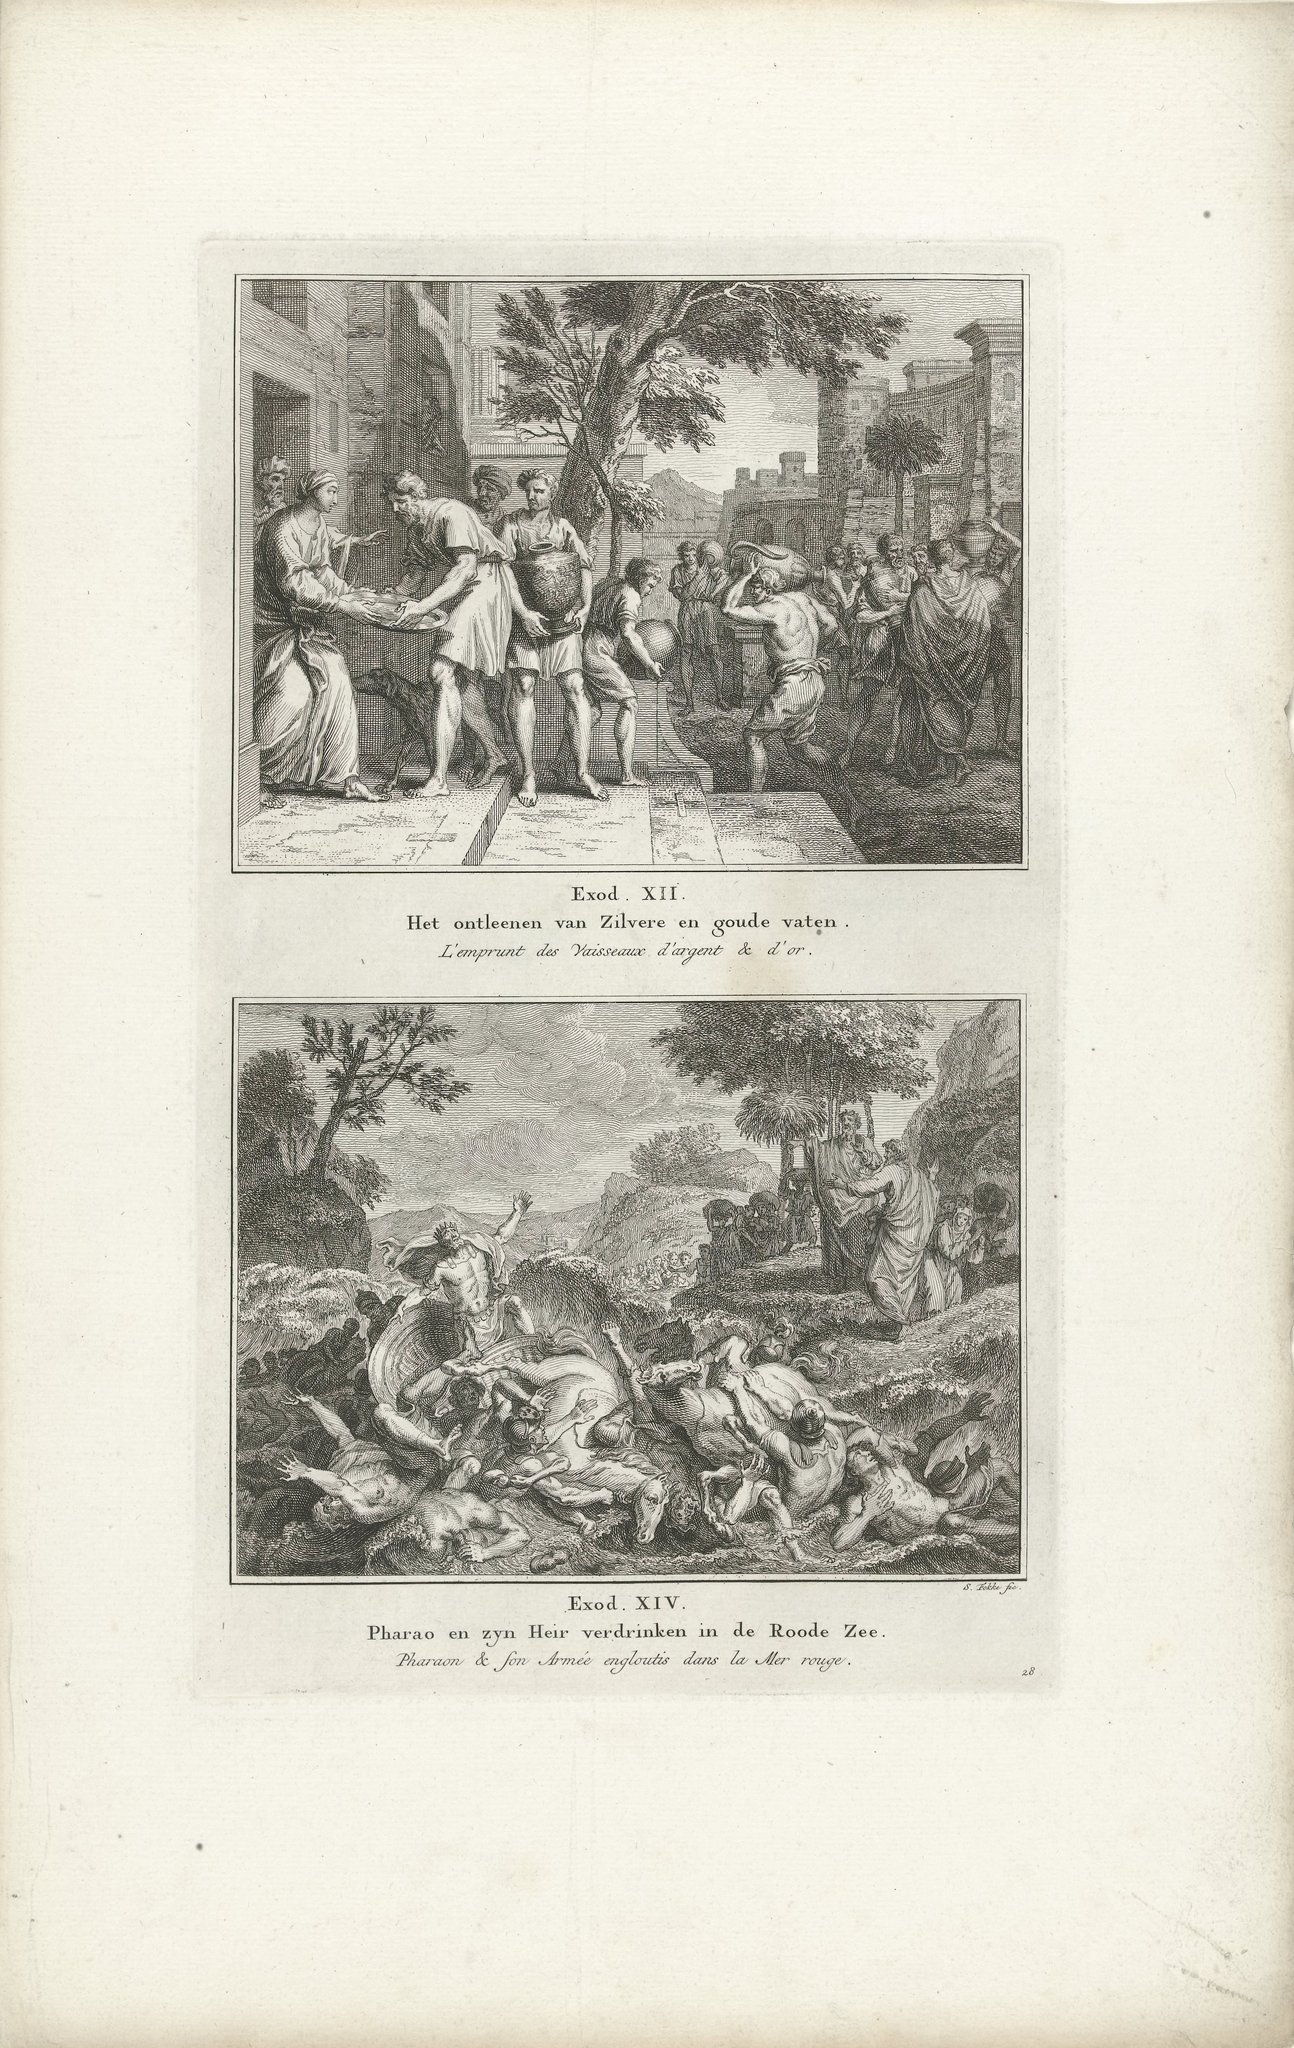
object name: print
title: Overhandiging van gouden en zilveren vaten en de farao verdrinkt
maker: simon fokke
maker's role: draughtsman, print maker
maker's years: 1712-1784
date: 1791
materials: paper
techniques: etching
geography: amsterdam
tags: pharaoh and his army engulfed in the red sea (israelites not or barely visible), the egyptians handing over their jewellery and clothing to the israelites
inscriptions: collector's mark, collector's mark: Lugt 2233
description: Twee Bijbelse voorstellingen uit Ex. 12 en 14. Genummerd rechtsonder: 28.